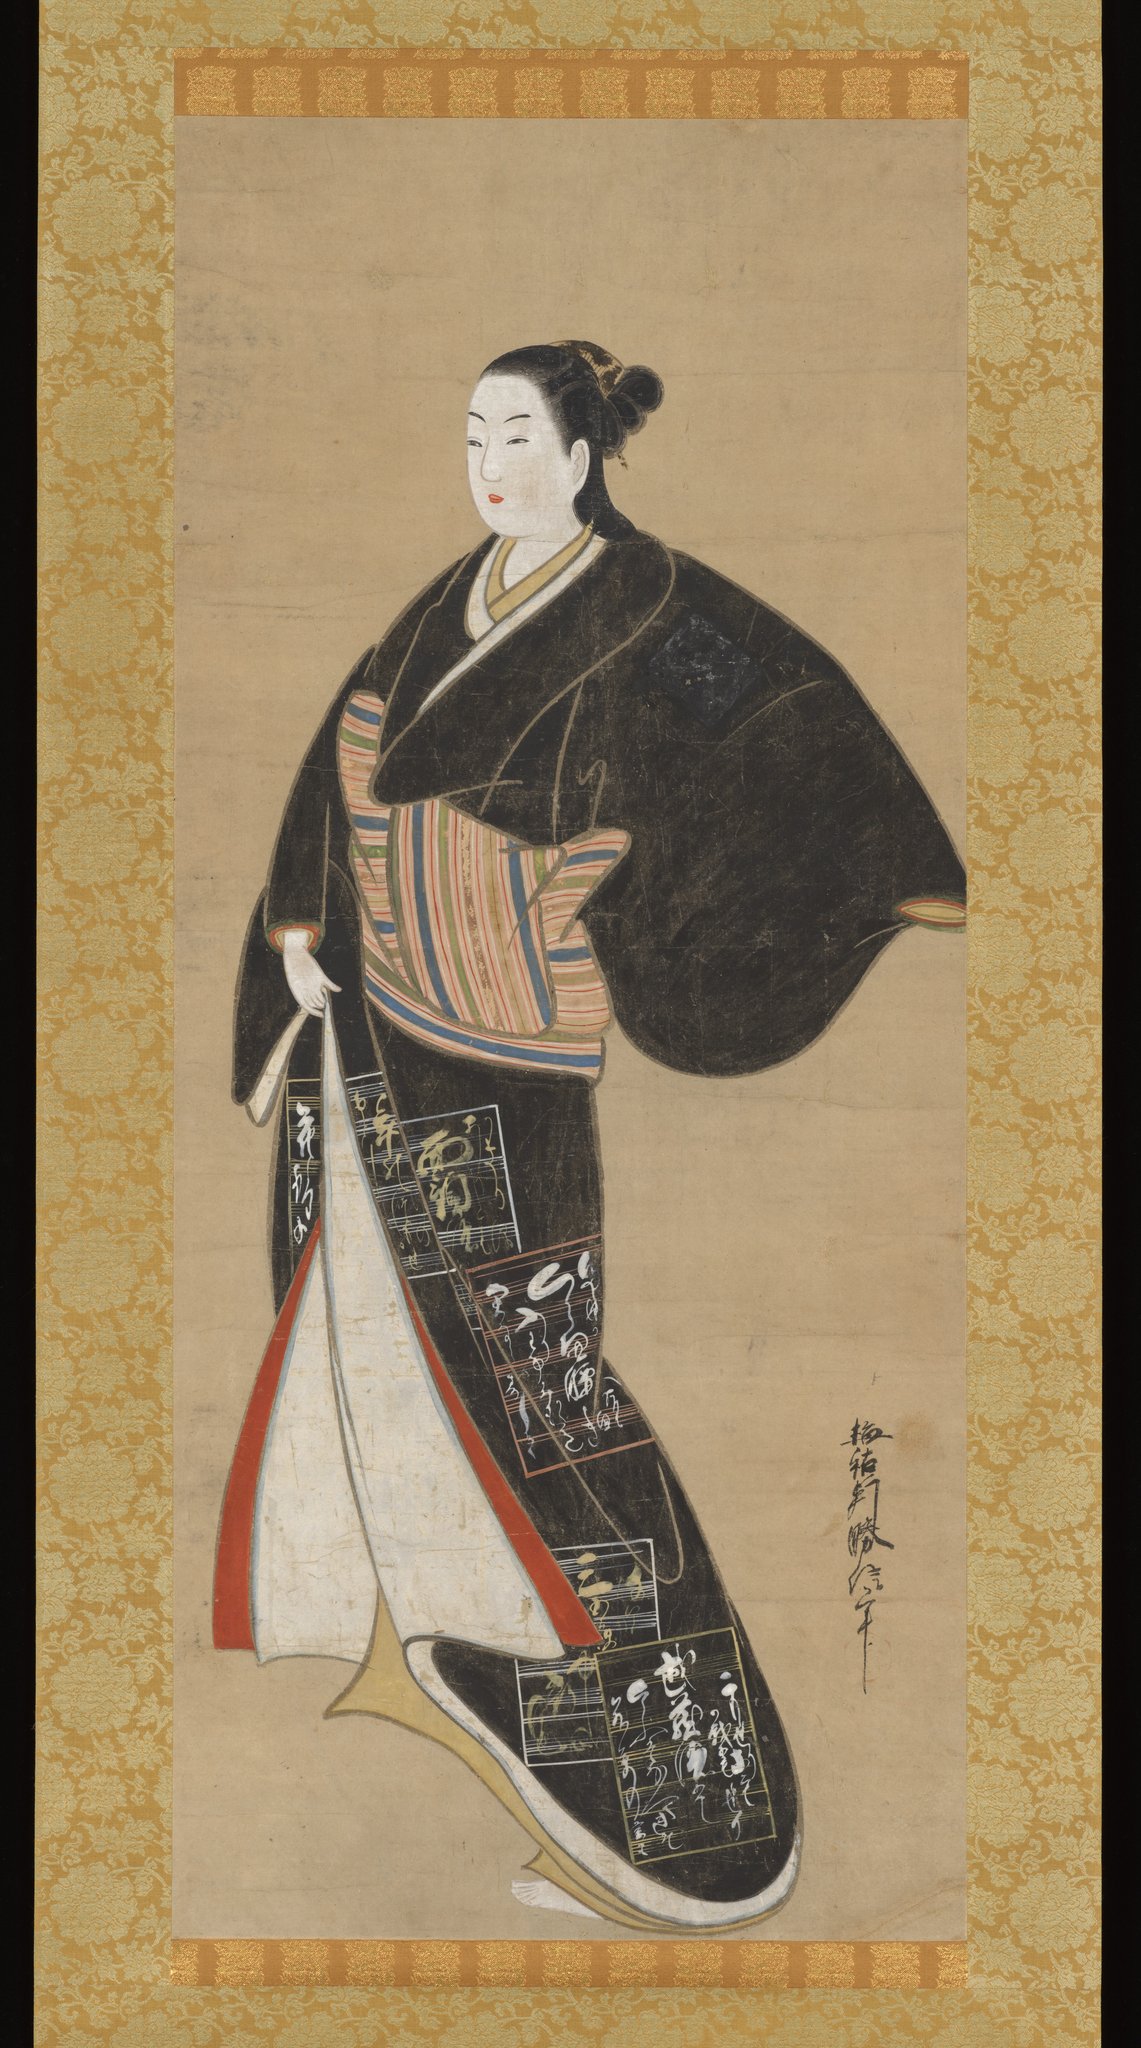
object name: hanging scroll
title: Standing Beauty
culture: japanese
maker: kondo katsunobu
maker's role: artist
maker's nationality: japanese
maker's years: 1716-1736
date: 1701-1800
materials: ink, paper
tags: women